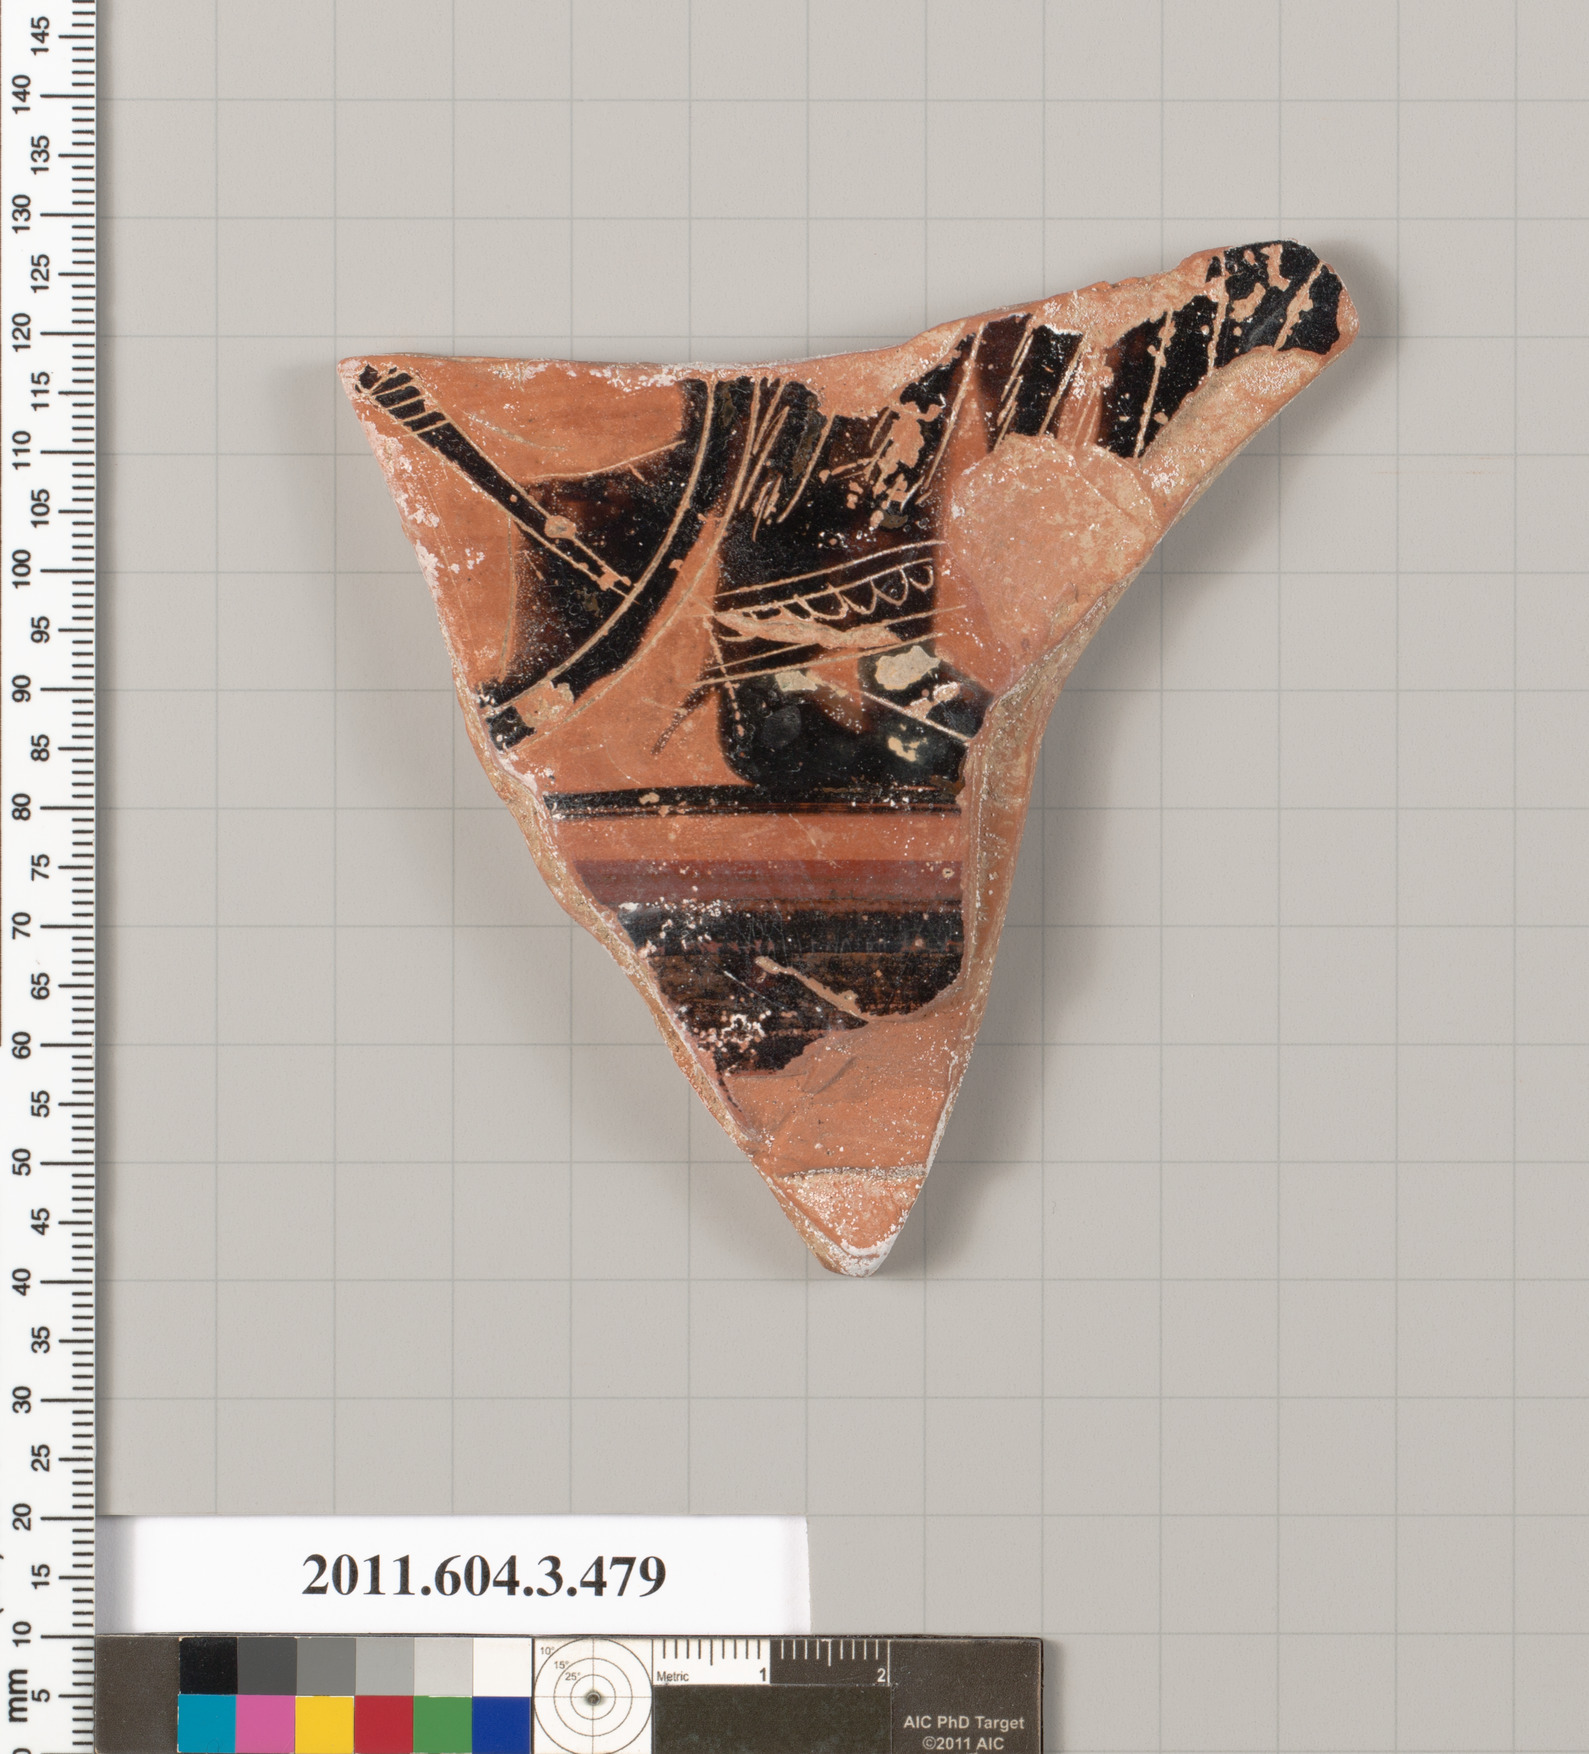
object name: neck amphora fragment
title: Terracotta fragment of a neck-amphora of Panathenaic shape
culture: greek, attic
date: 534-468 BCE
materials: terracotta